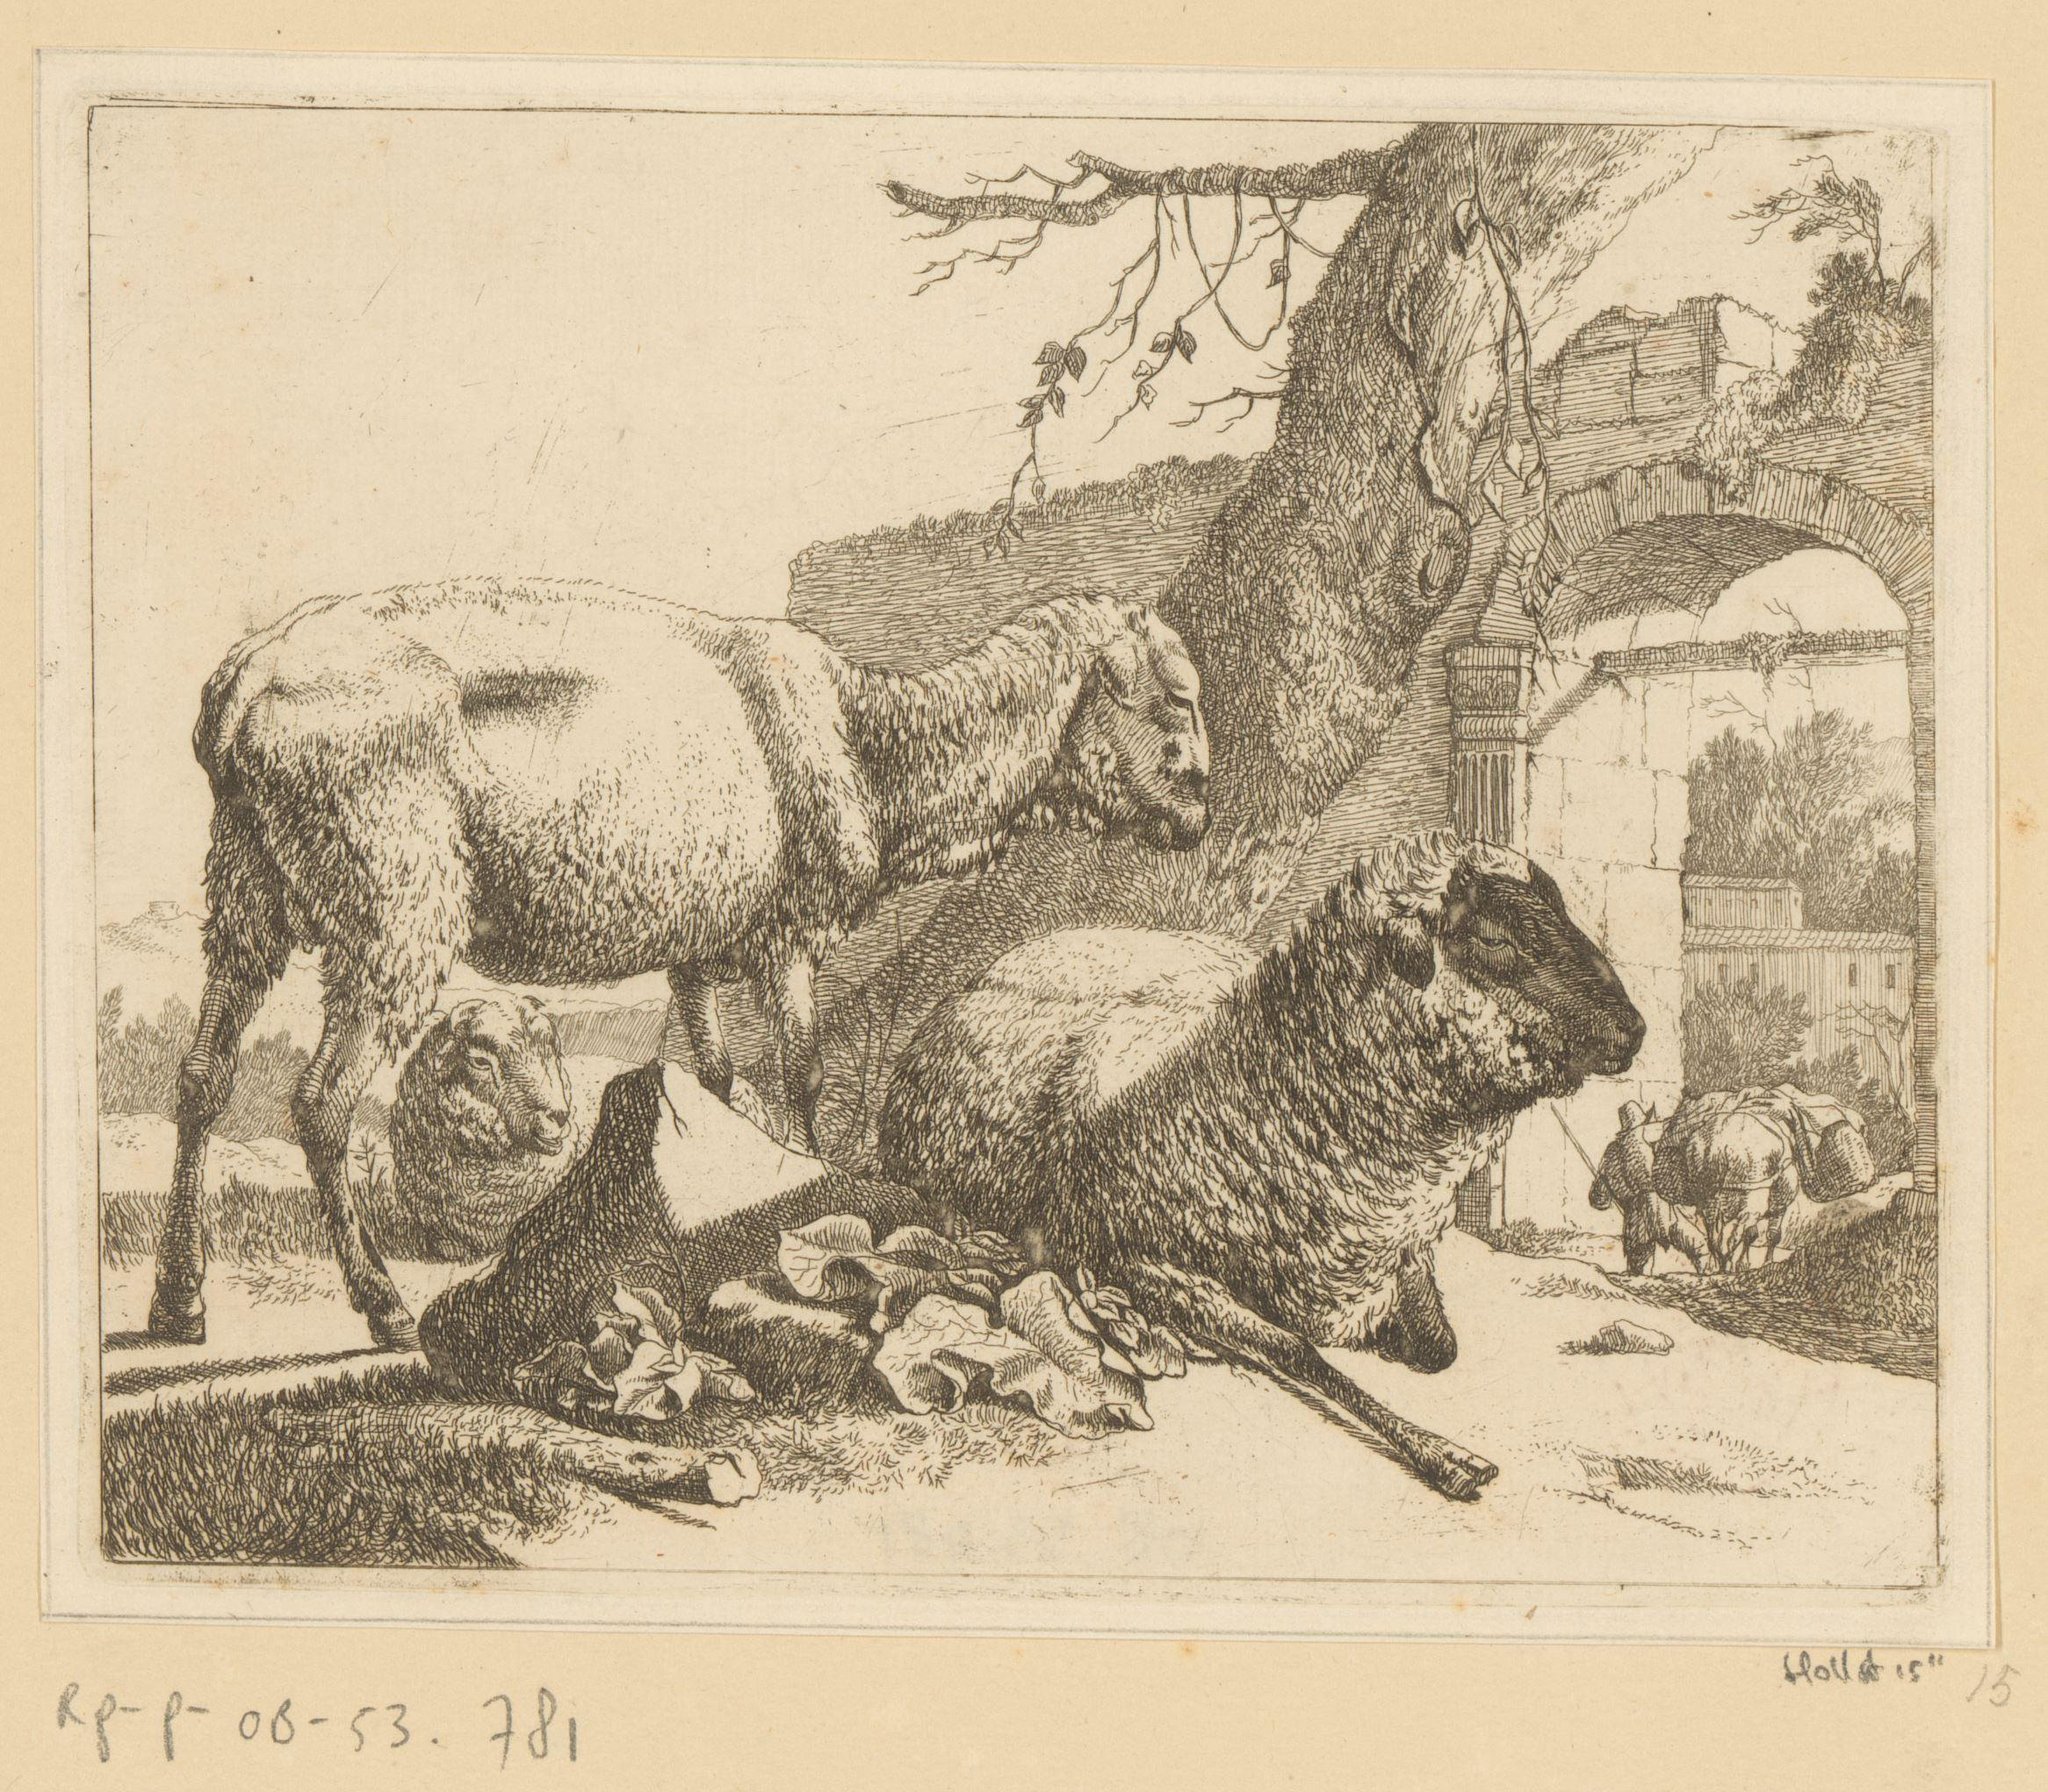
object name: print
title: Schapen en geiten bij ruïnes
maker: johann heinrich roos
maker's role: draughtsman, print maker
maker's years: 1631-1685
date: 1665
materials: paper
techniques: engraving, etching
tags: landscape with ruins, sheep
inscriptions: collector's mark: Lugt 240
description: Serie van acht prenten, waarvan één titelprent.